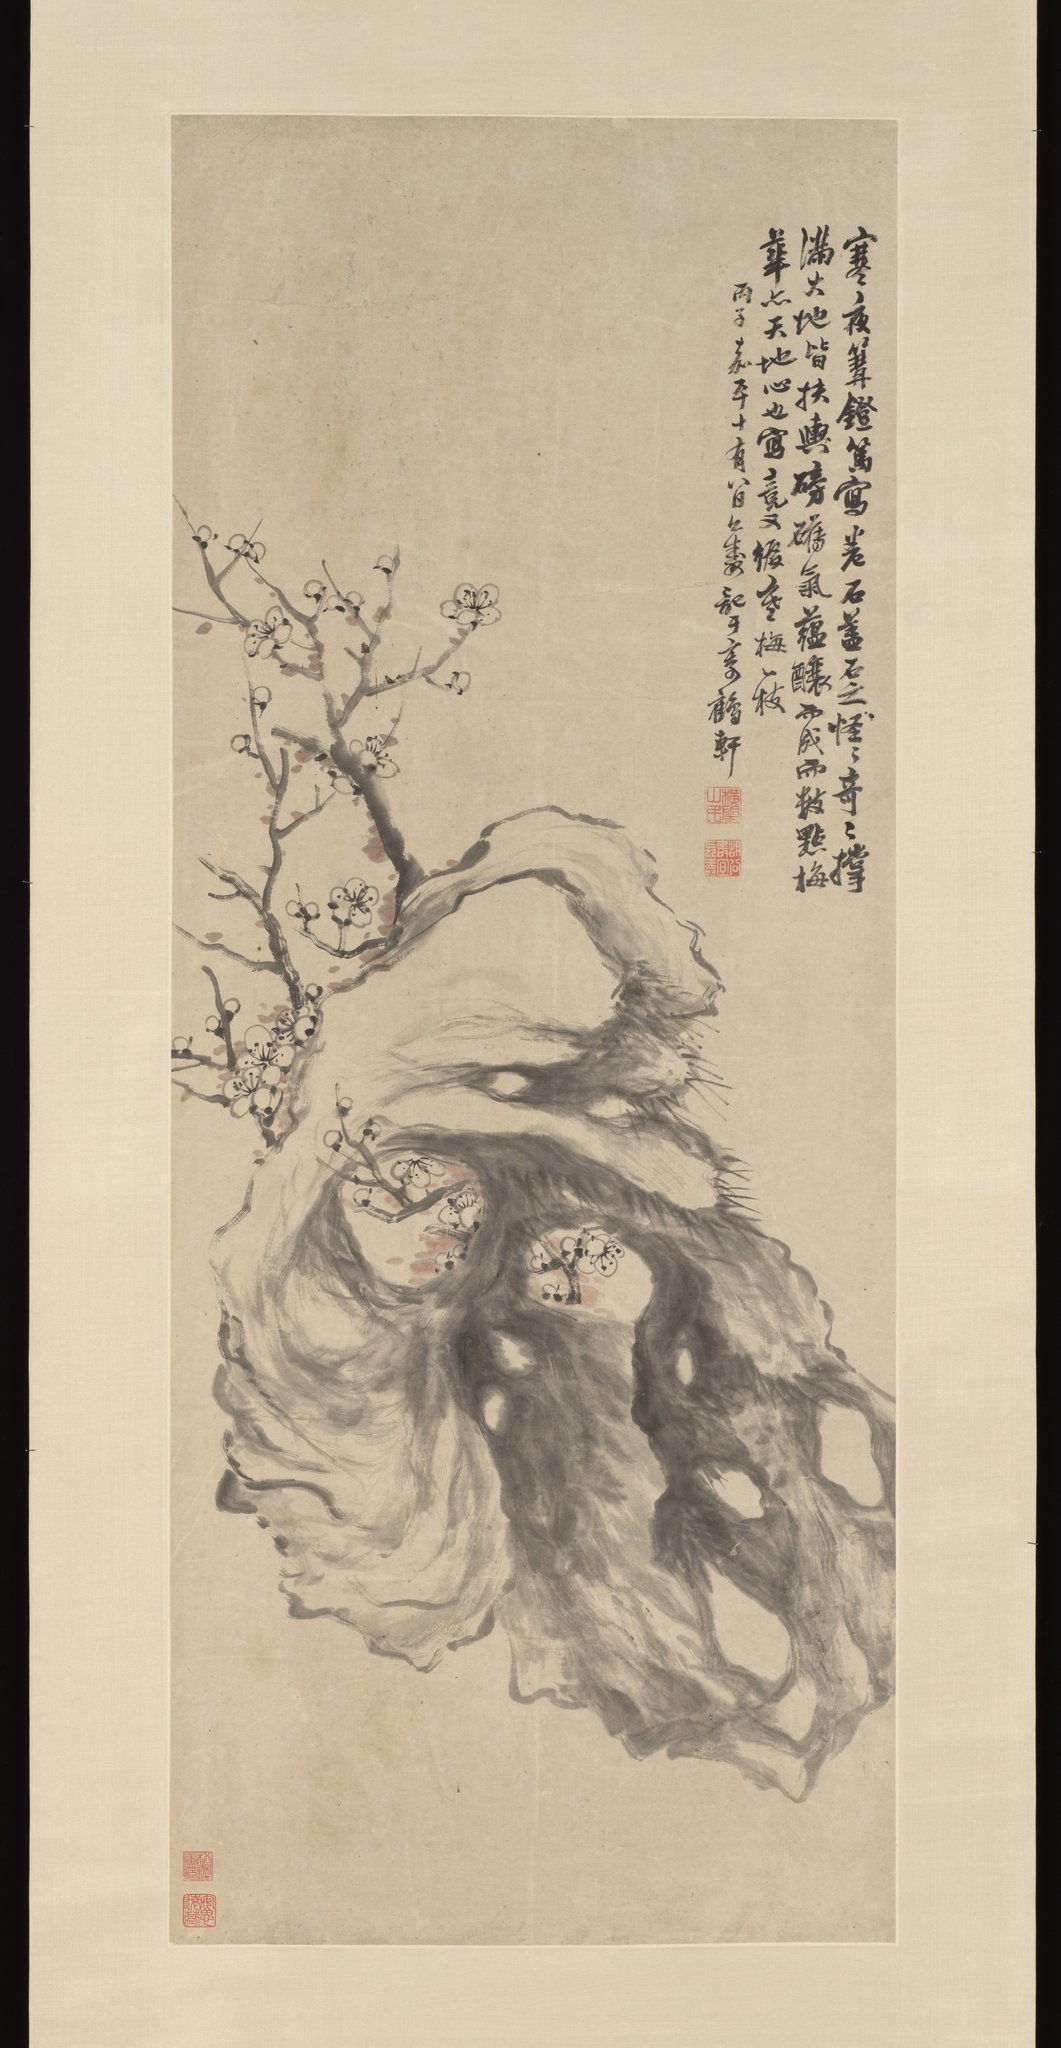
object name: hanging scroll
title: Flowering Plum and Rock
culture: chinese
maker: hu yuan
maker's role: artist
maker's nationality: chinese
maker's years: 1823-1886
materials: ink, paper